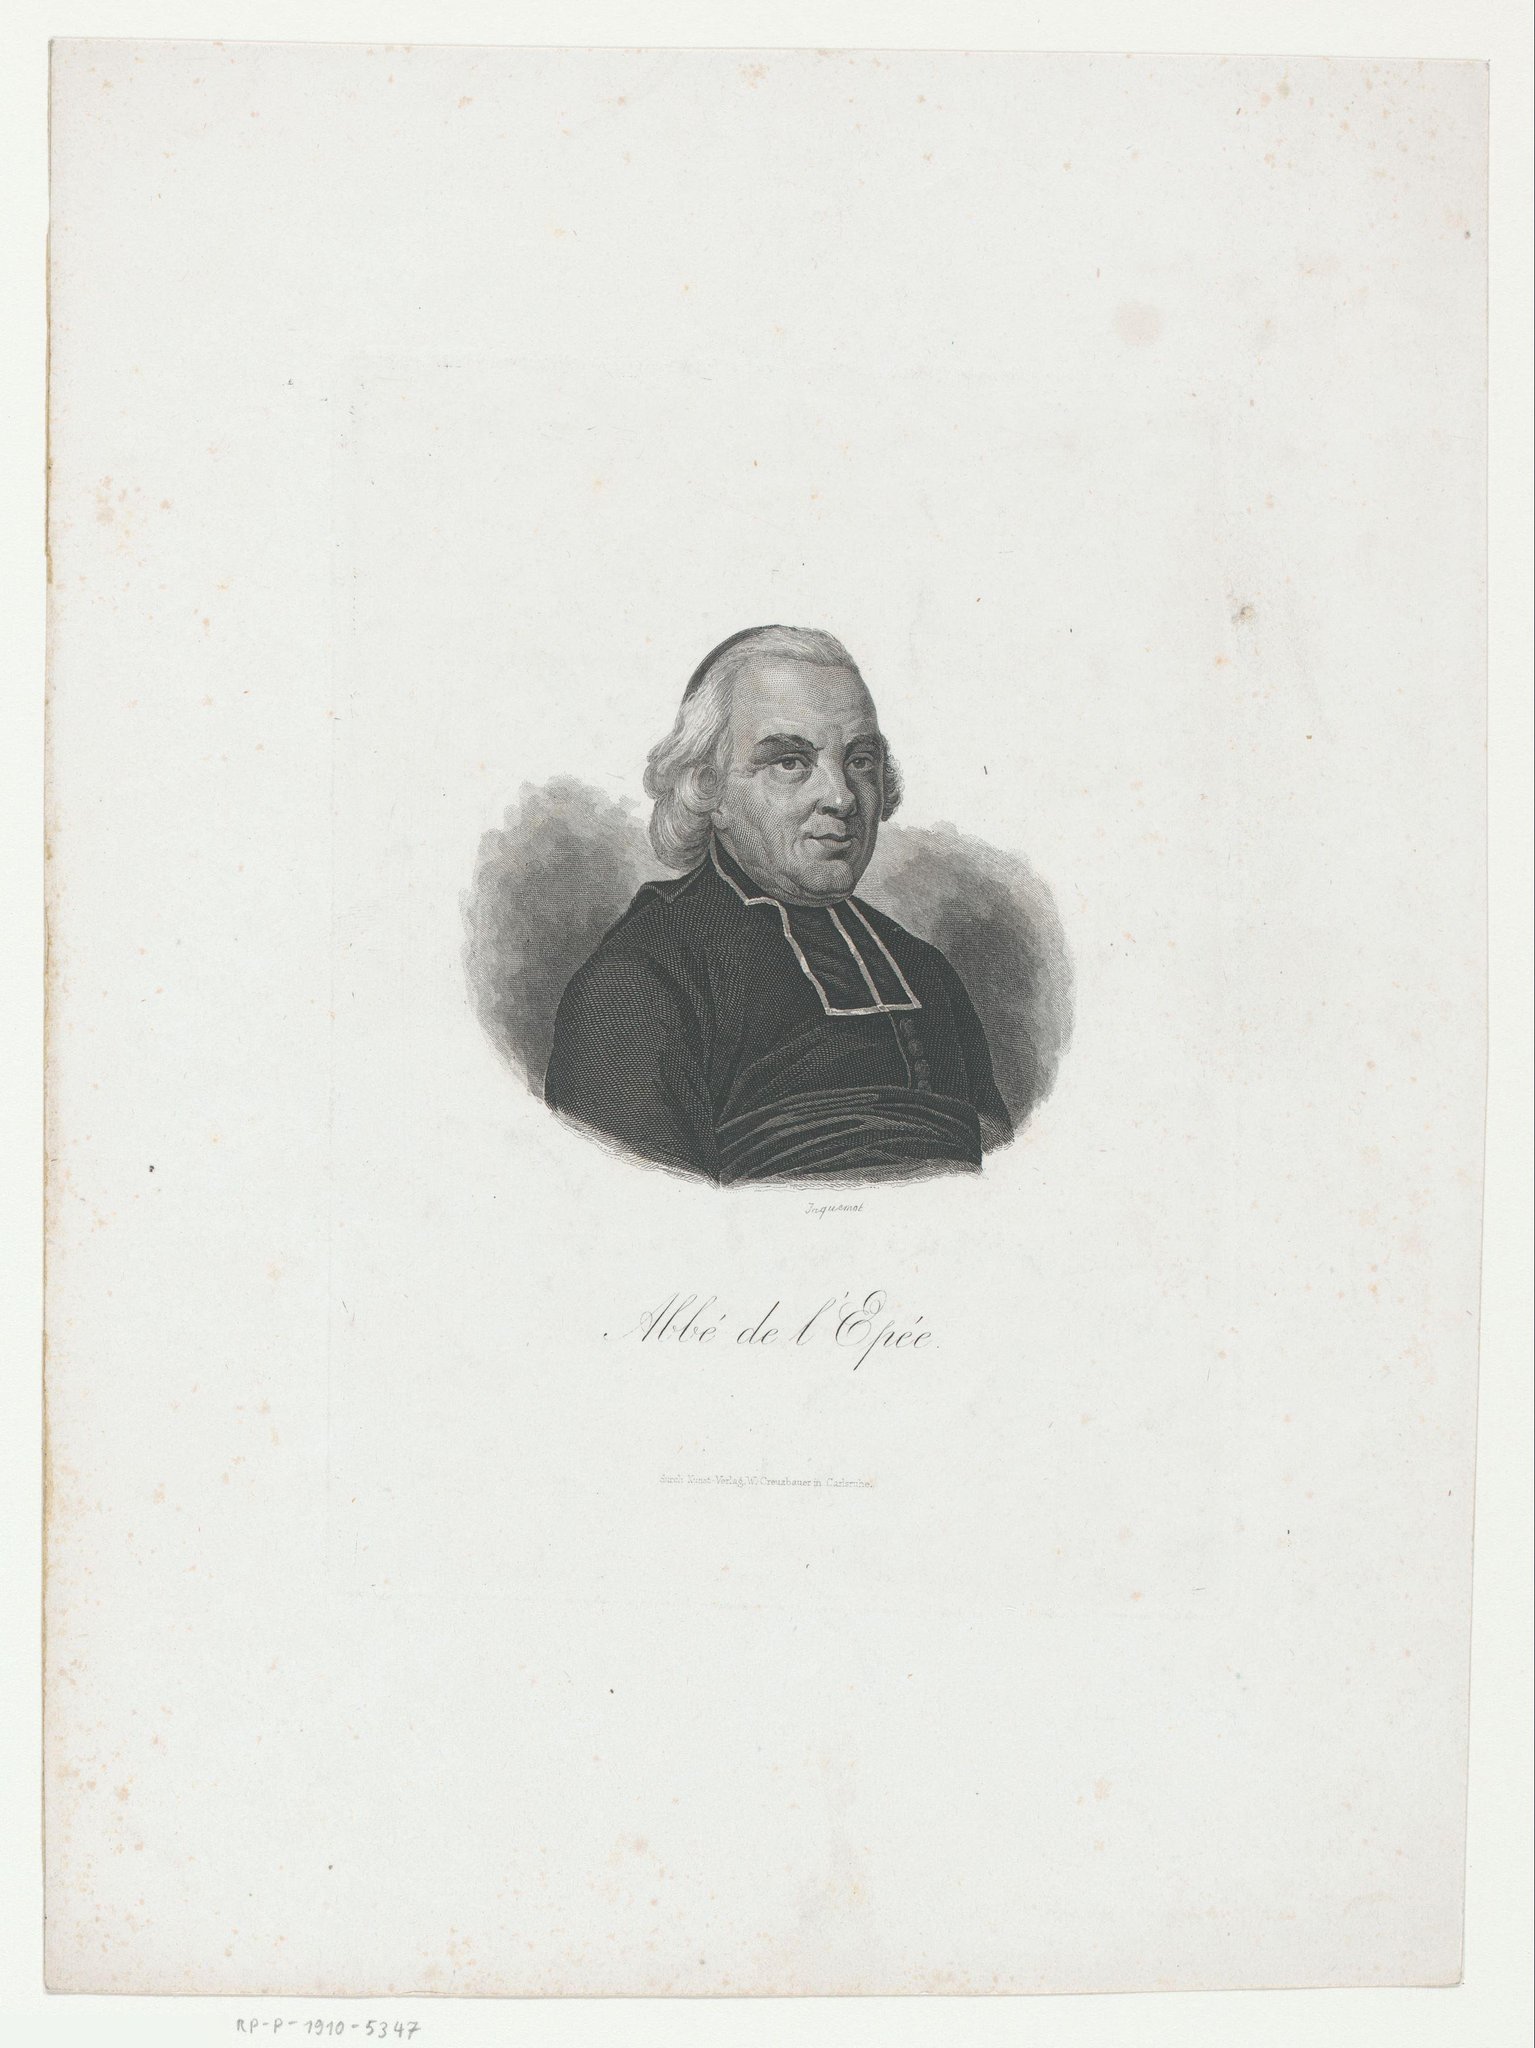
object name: print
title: Abbé de l'Epée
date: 1816-1880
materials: paper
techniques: etching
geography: france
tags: paris, historical persons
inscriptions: collector's mark: Lugt 2228